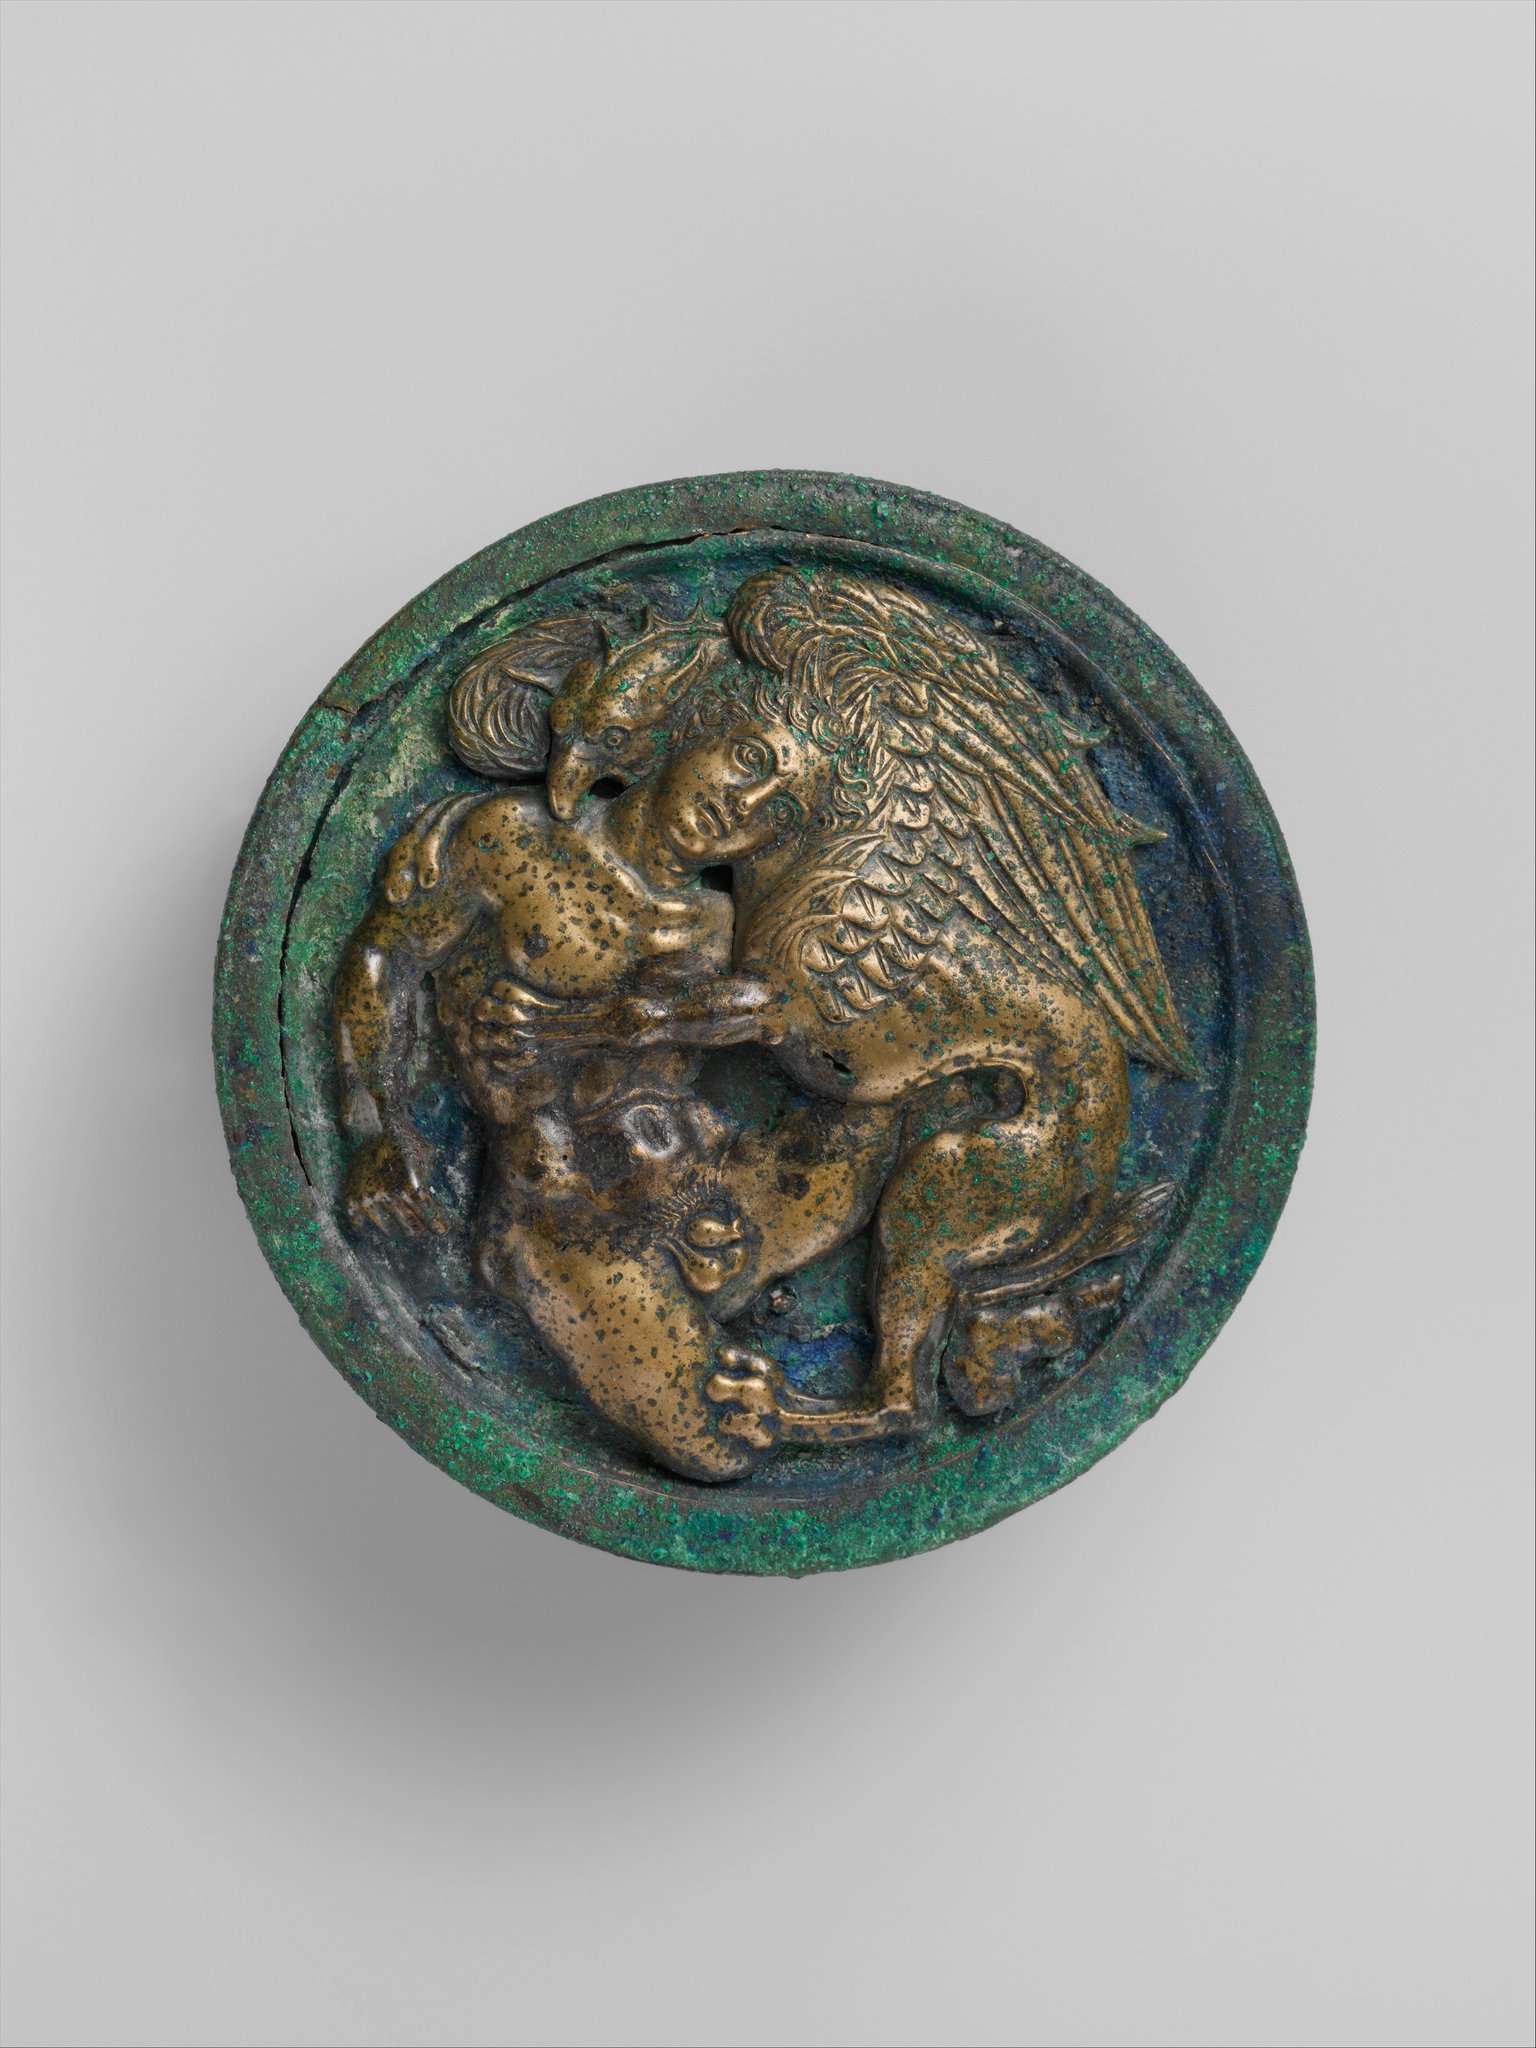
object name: lid of a perfume vase with griffin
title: Bronze lid and upper part of an oil flask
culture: praenestine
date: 400-301 BCE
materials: bronze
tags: male nudes,griffins